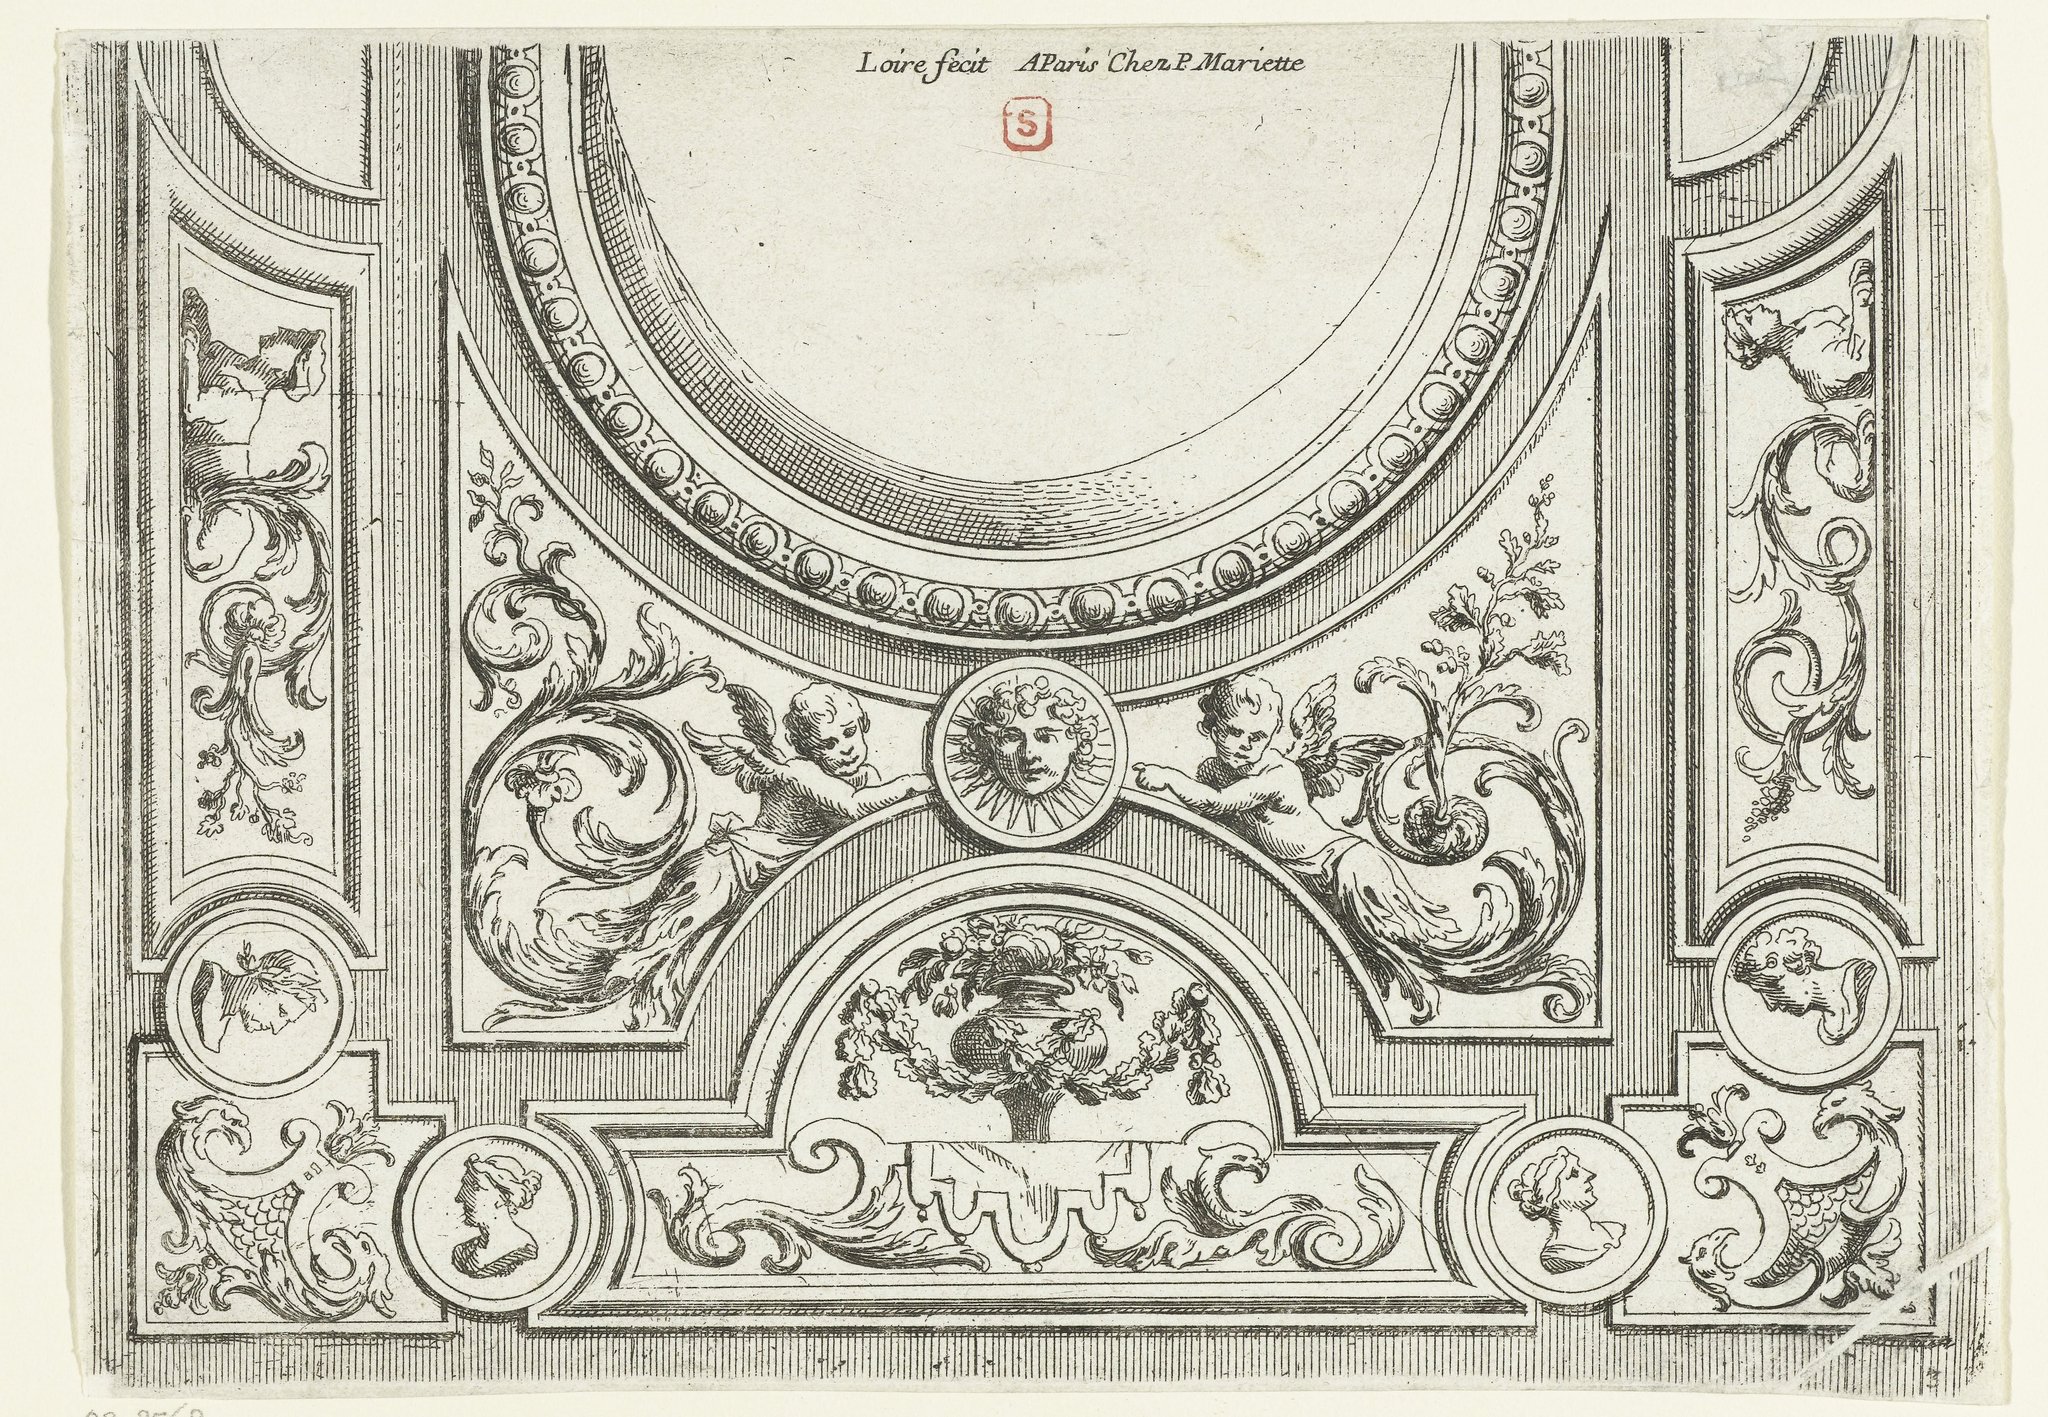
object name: ornament print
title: Plafonds à la moderne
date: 1634-1716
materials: paper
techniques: etching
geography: paris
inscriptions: collector's mark: Lugt 2342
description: In het midden een leeg rond vlak omringd door kleine panelen met bladranken en portretmedaillons. Uit tweede editie.